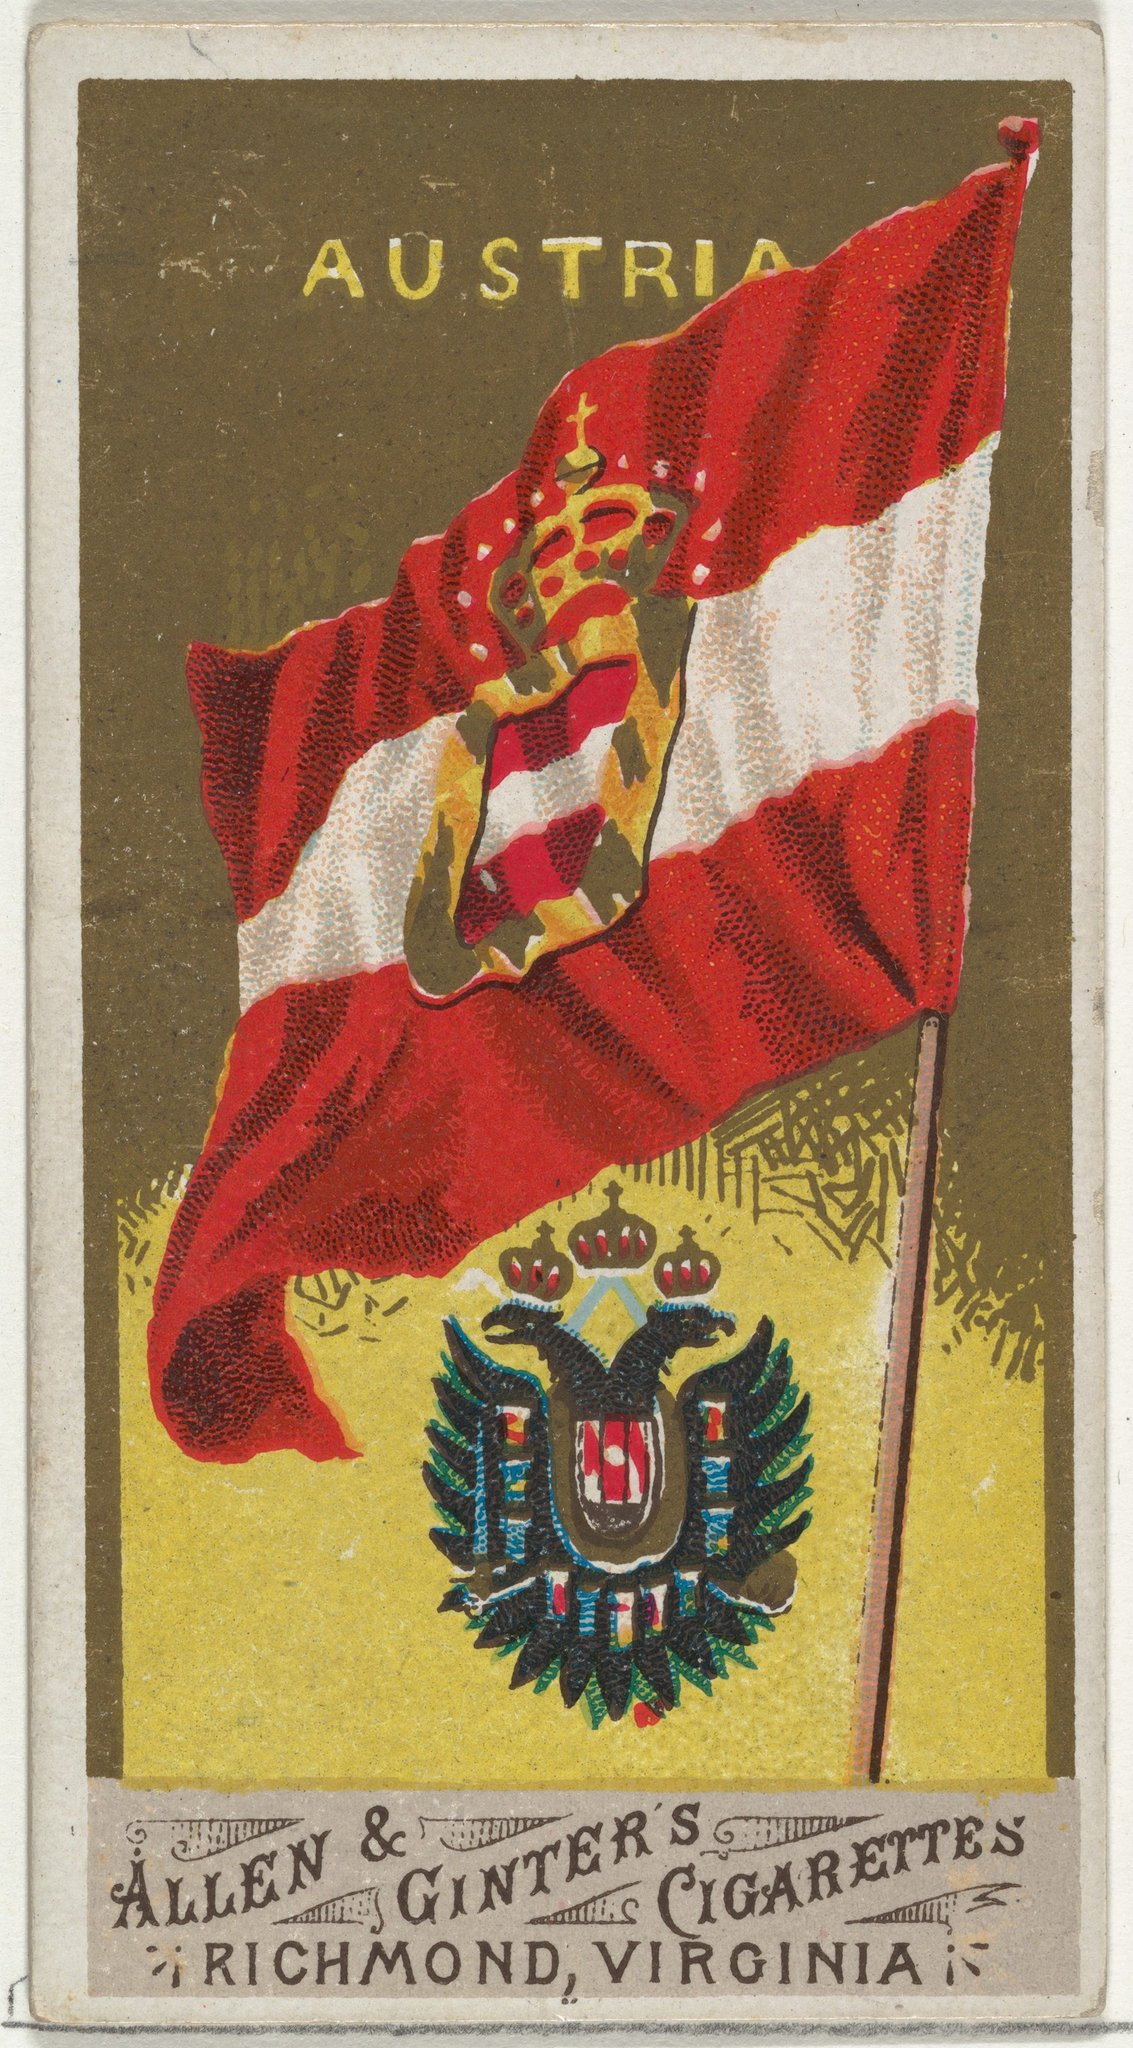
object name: print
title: Austria, from Flags of All Nations, Series 1 (N9) for Allen & Ginter Cigarettes Brands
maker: allen & ginter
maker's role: publisher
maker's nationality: american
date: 1887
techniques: color lithograph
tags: coat of arms,flags